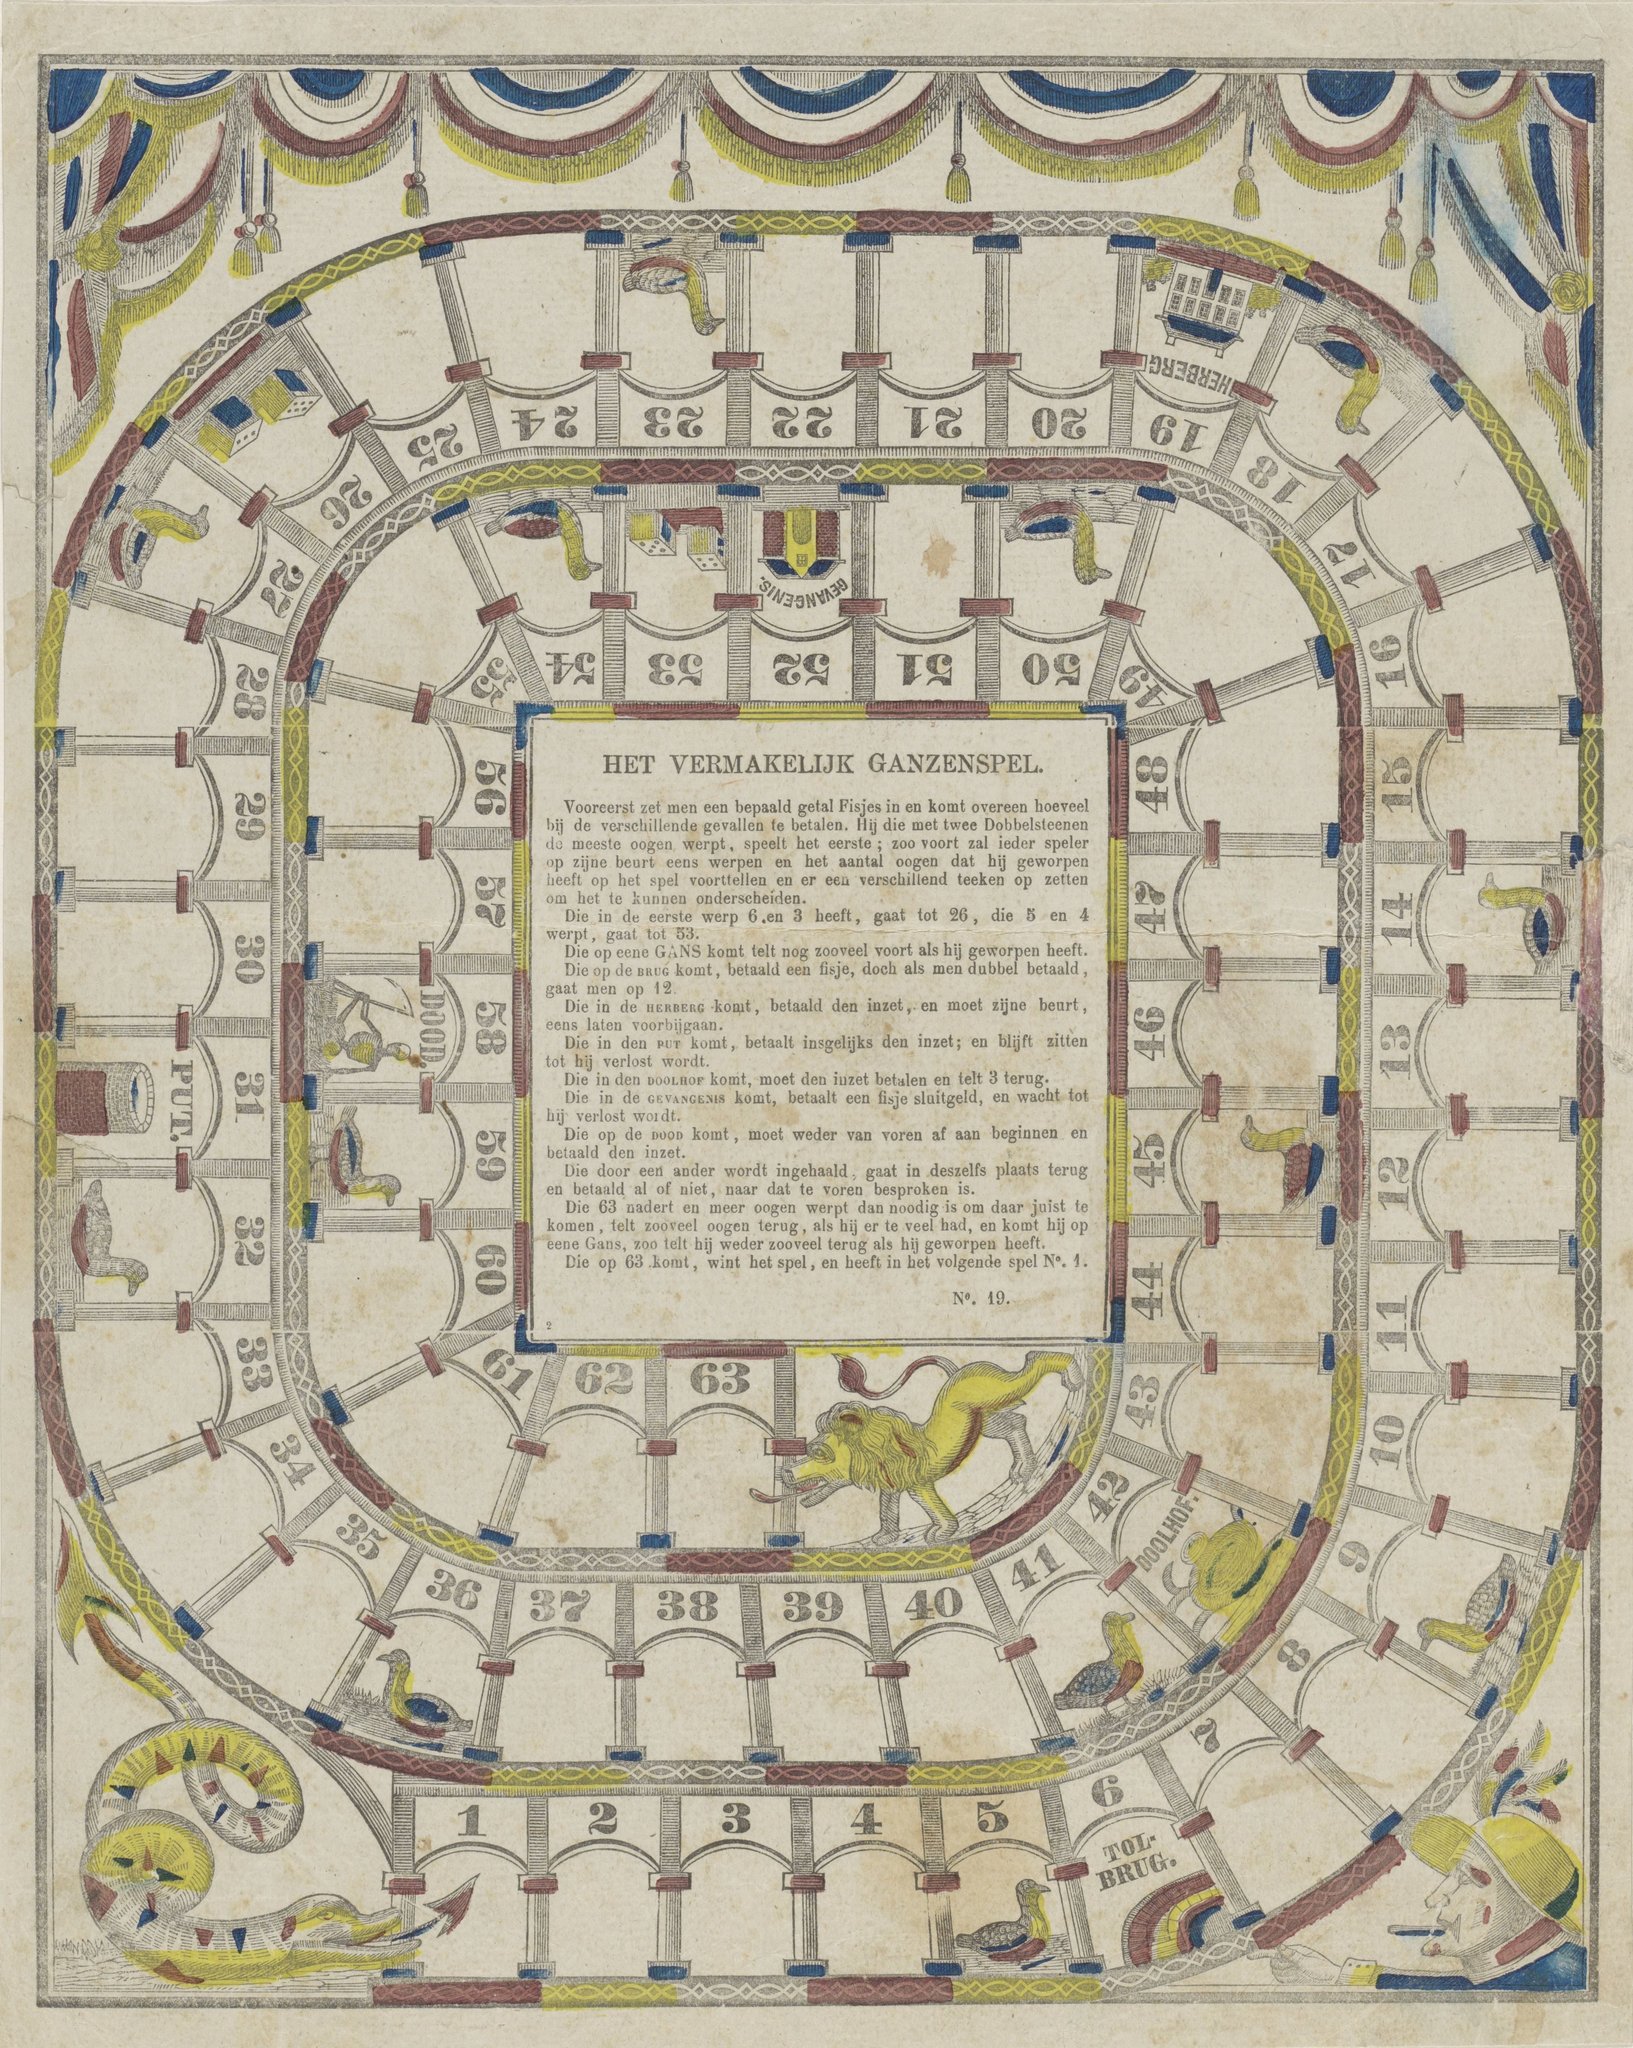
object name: game of goose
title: Het vermakelijk ganzenspel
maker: Anonymous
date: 1848-1881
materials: paper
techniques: colour, letterpress printing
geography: den bosch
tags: goose-game, board-games of chance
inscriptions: collector's mark: Lugt 2760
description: Een rechthoekig ganzenbordspel met vakjes genummerd 1-63. In het midden de spelregels. Genummerd midden: No. 19.